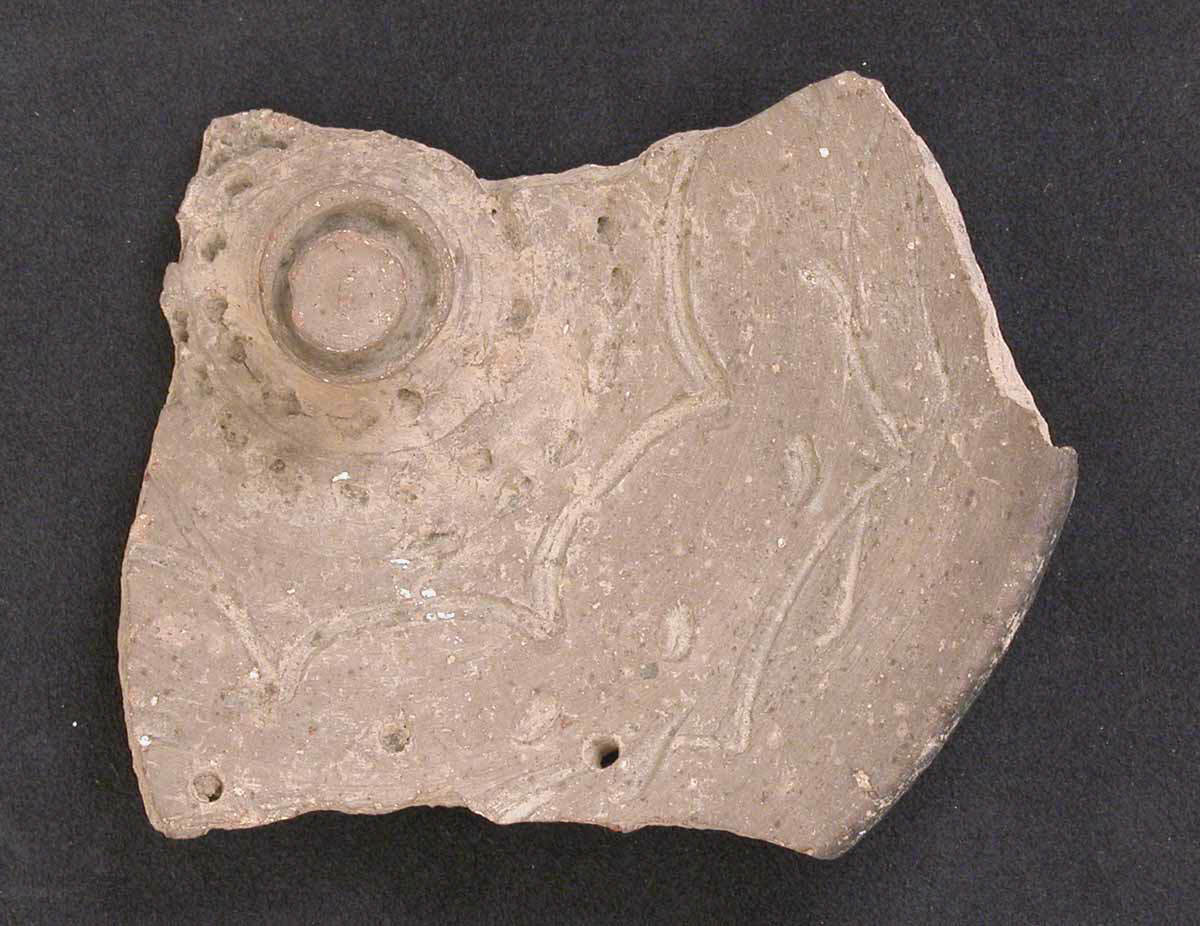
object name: fragment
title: Fragment of a Lid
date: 701-900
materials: earthenware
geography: iran